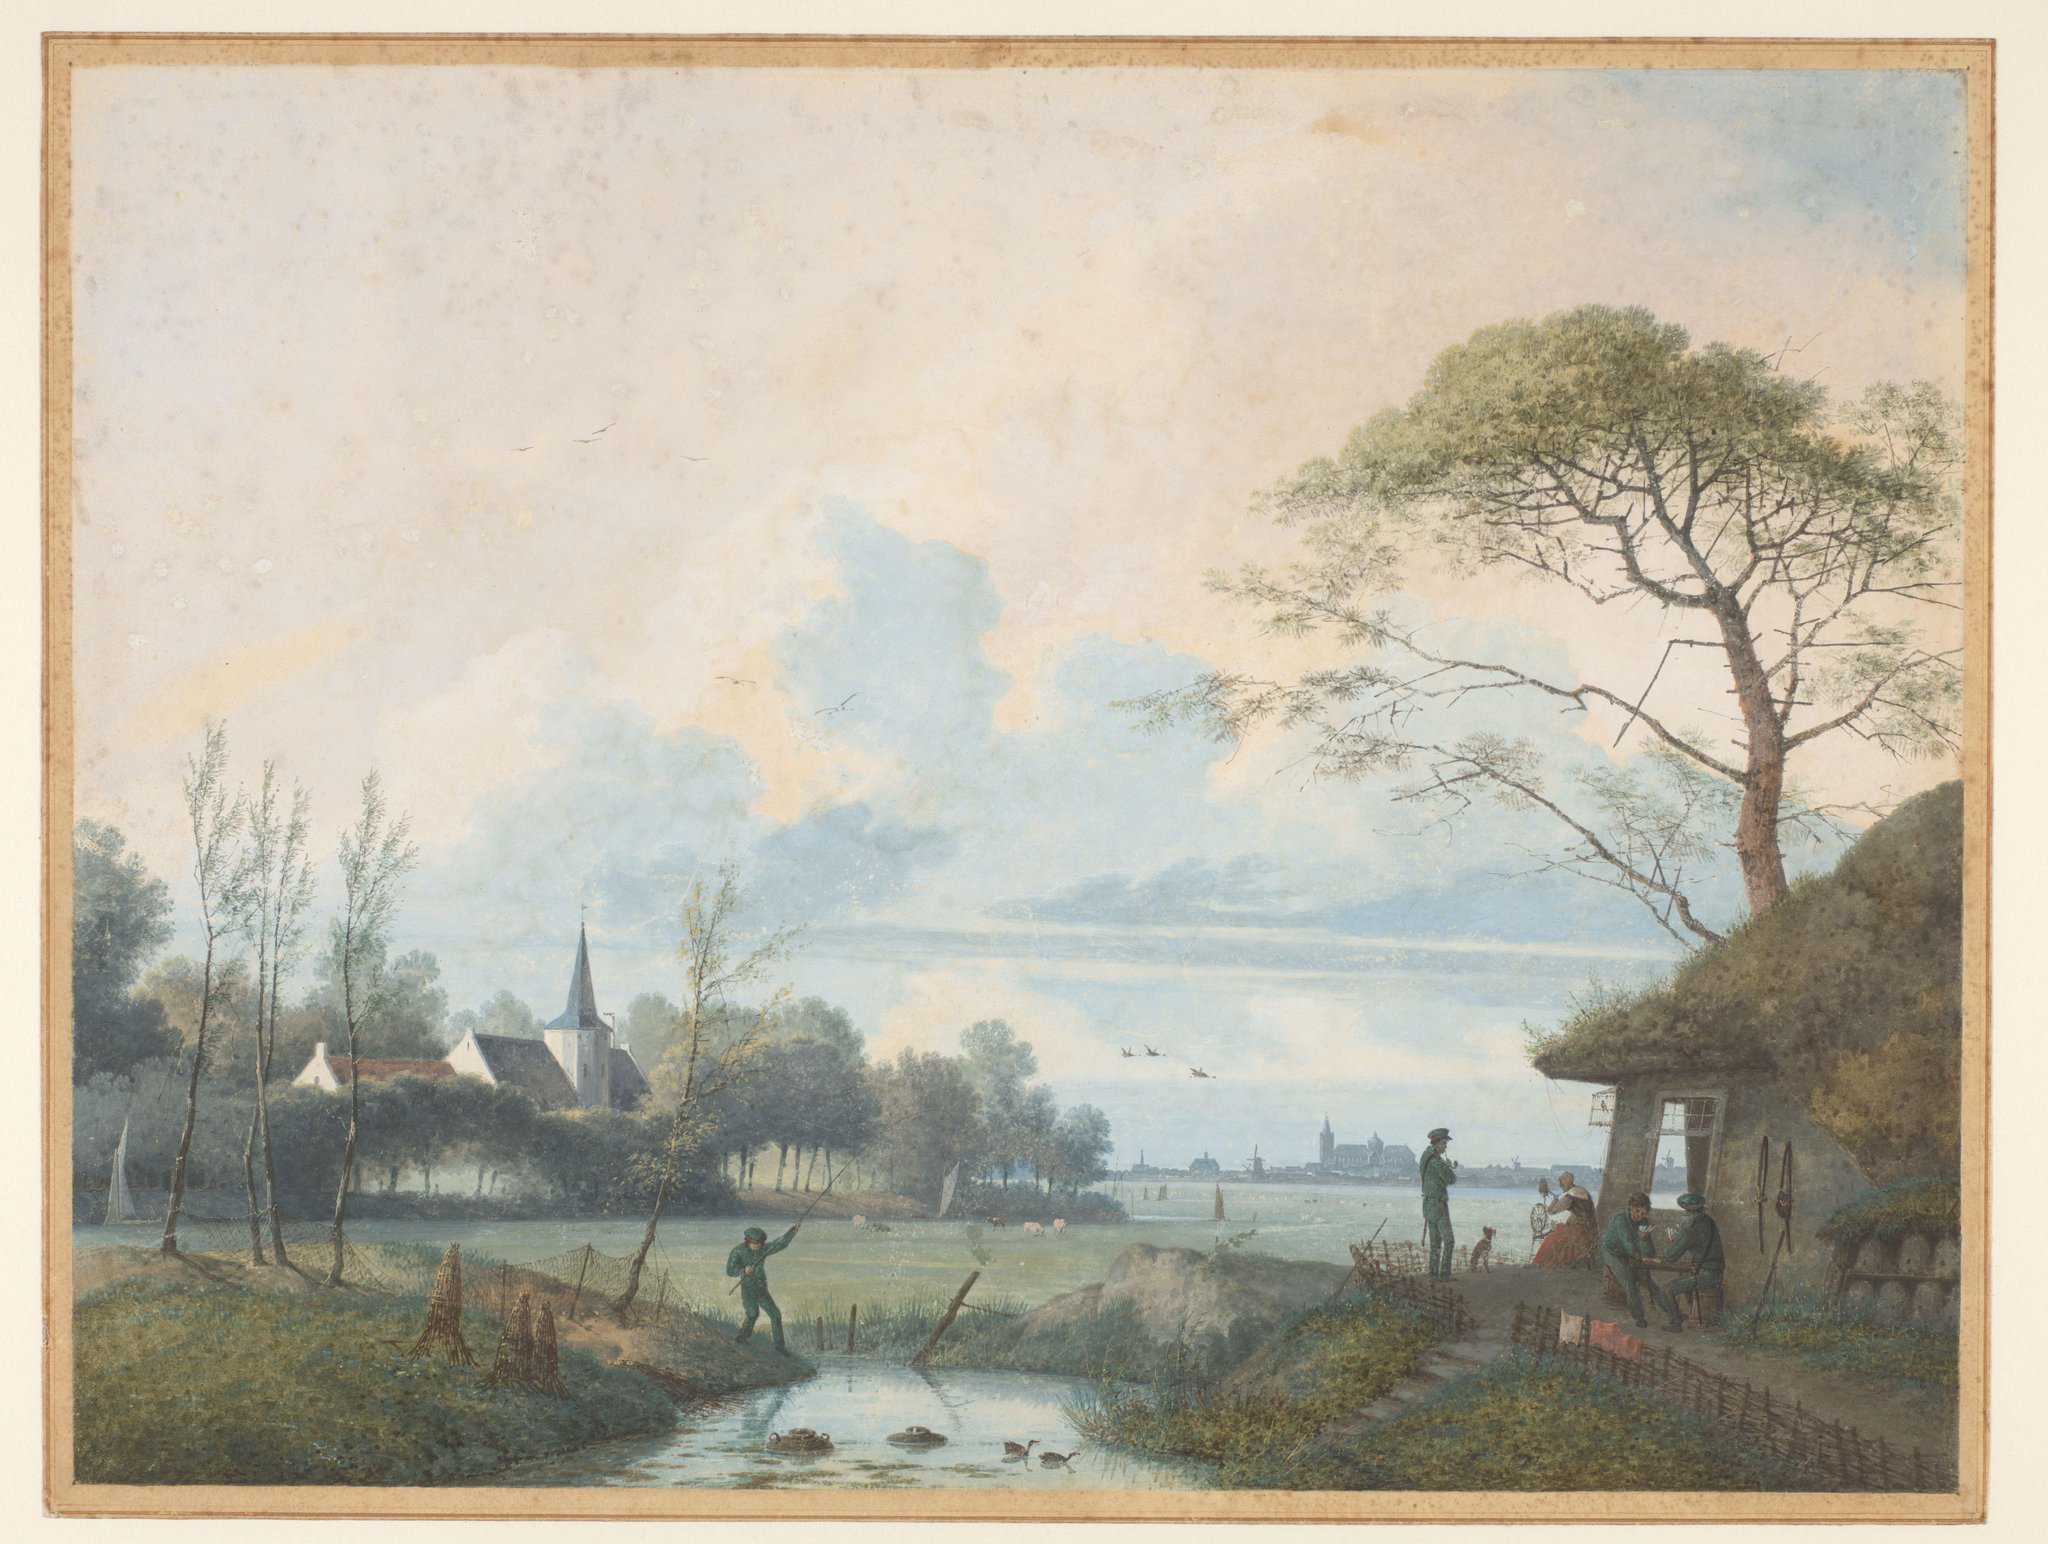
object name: drawing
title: Gezicht met een dorpskerk en 's-Hertogenbosch in het verschiet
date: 1831-1847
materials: gouache, paper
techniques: brush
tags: prospect of city, town panorama, silhouette of city, den bosch